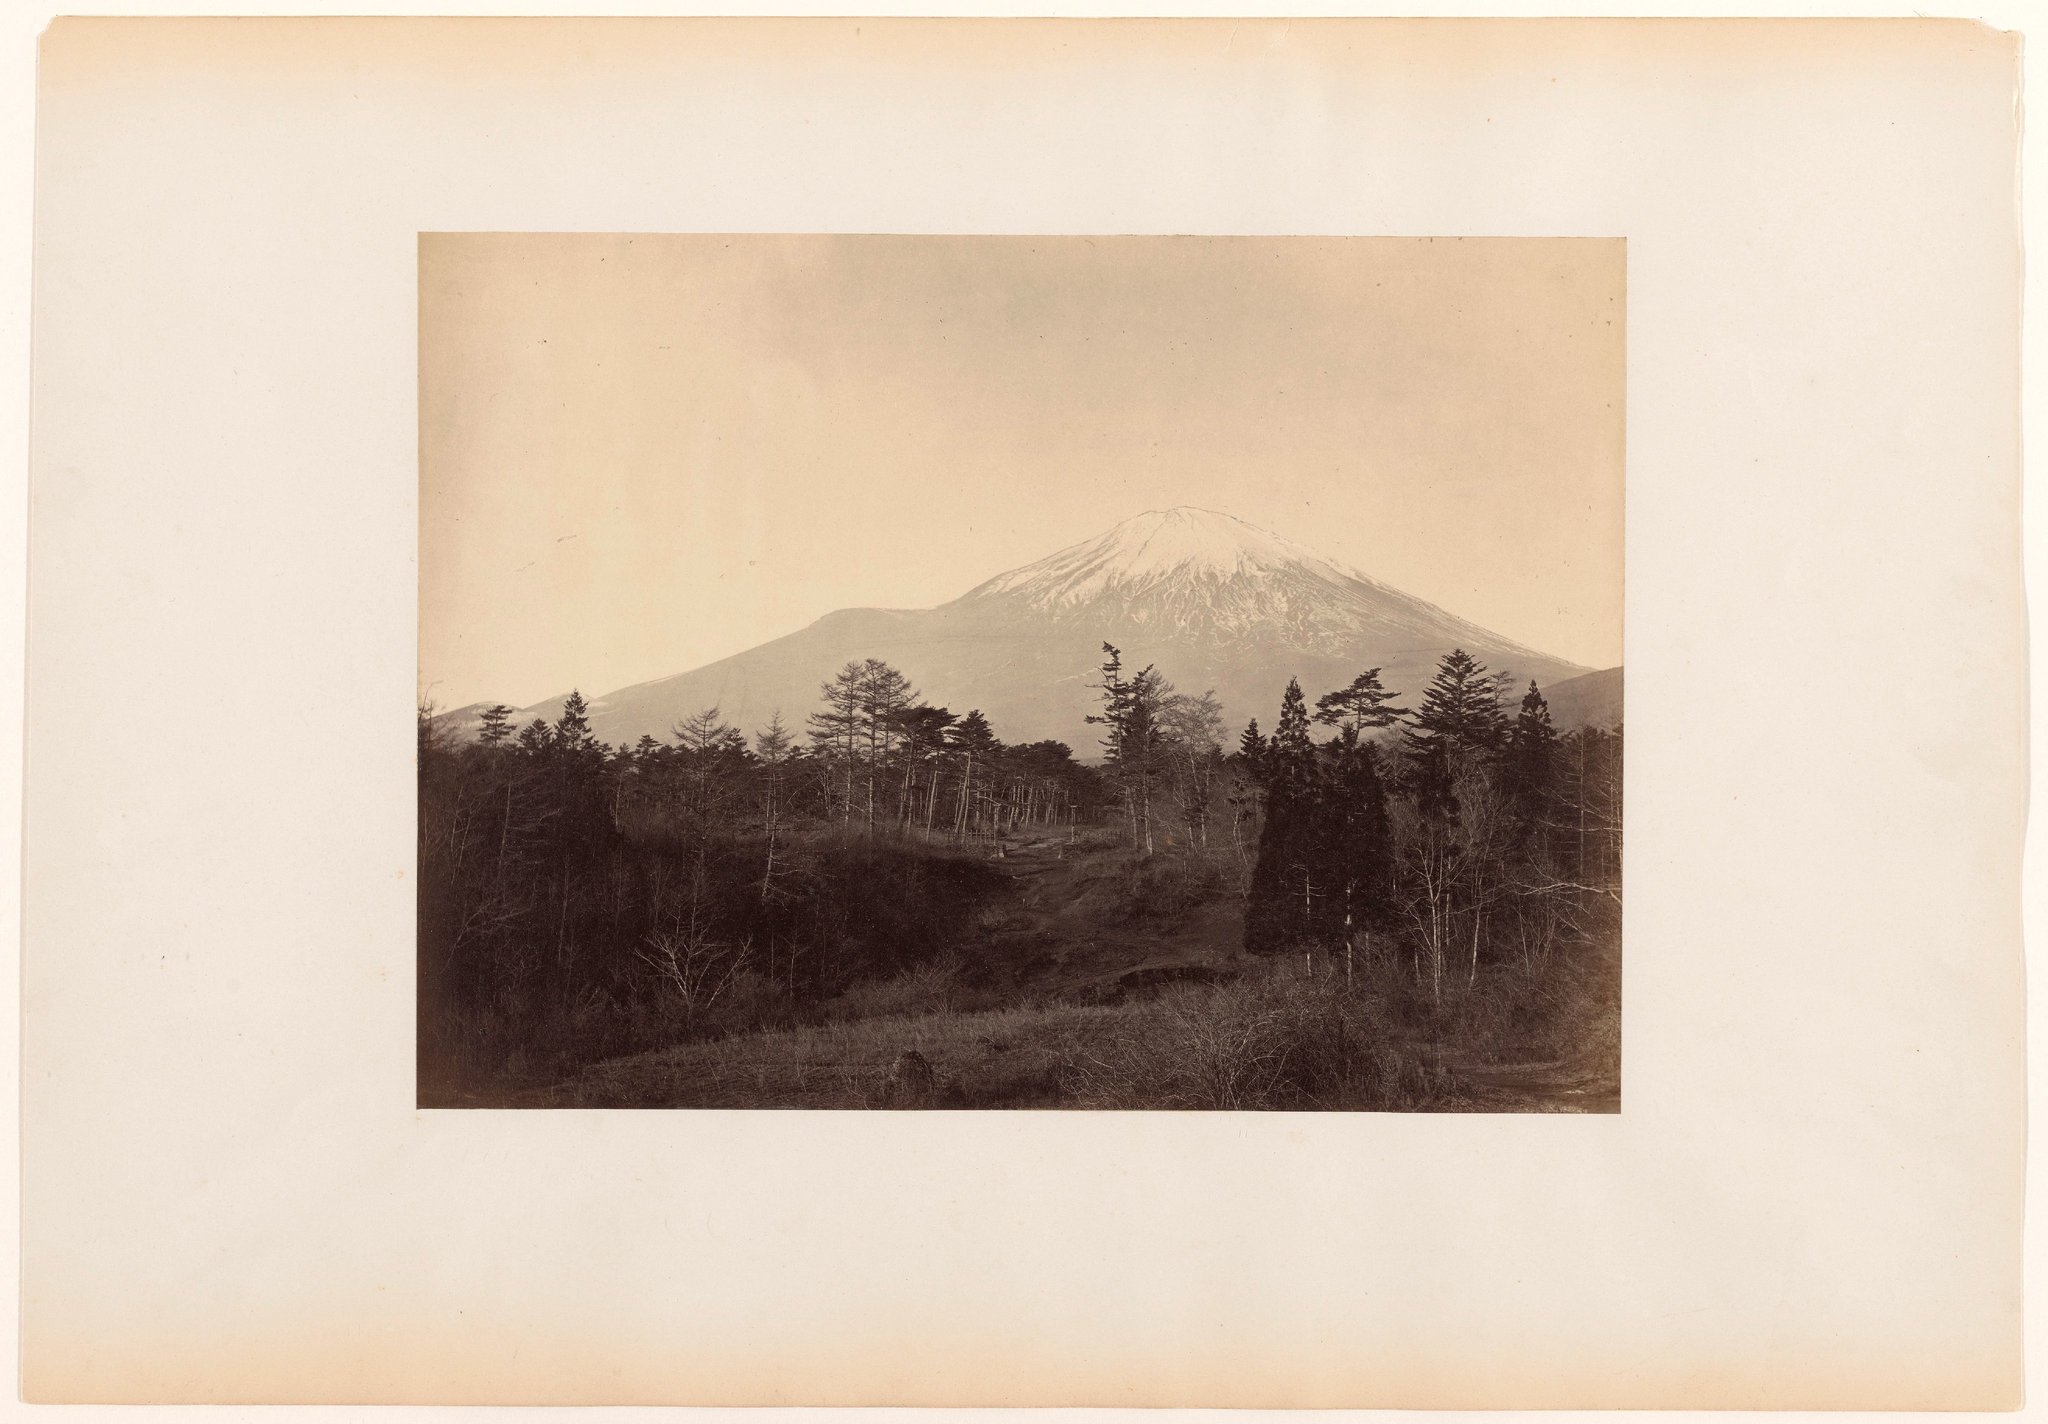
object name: photograph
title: Fusi-Yama from Yoshida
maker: felice beato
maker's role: fotograaf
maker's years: 1825-1909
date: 1867-1868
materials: paper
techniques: albumen print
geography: japan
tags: volcano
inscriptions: inscription: ‘THIS noble mountain, (...)’